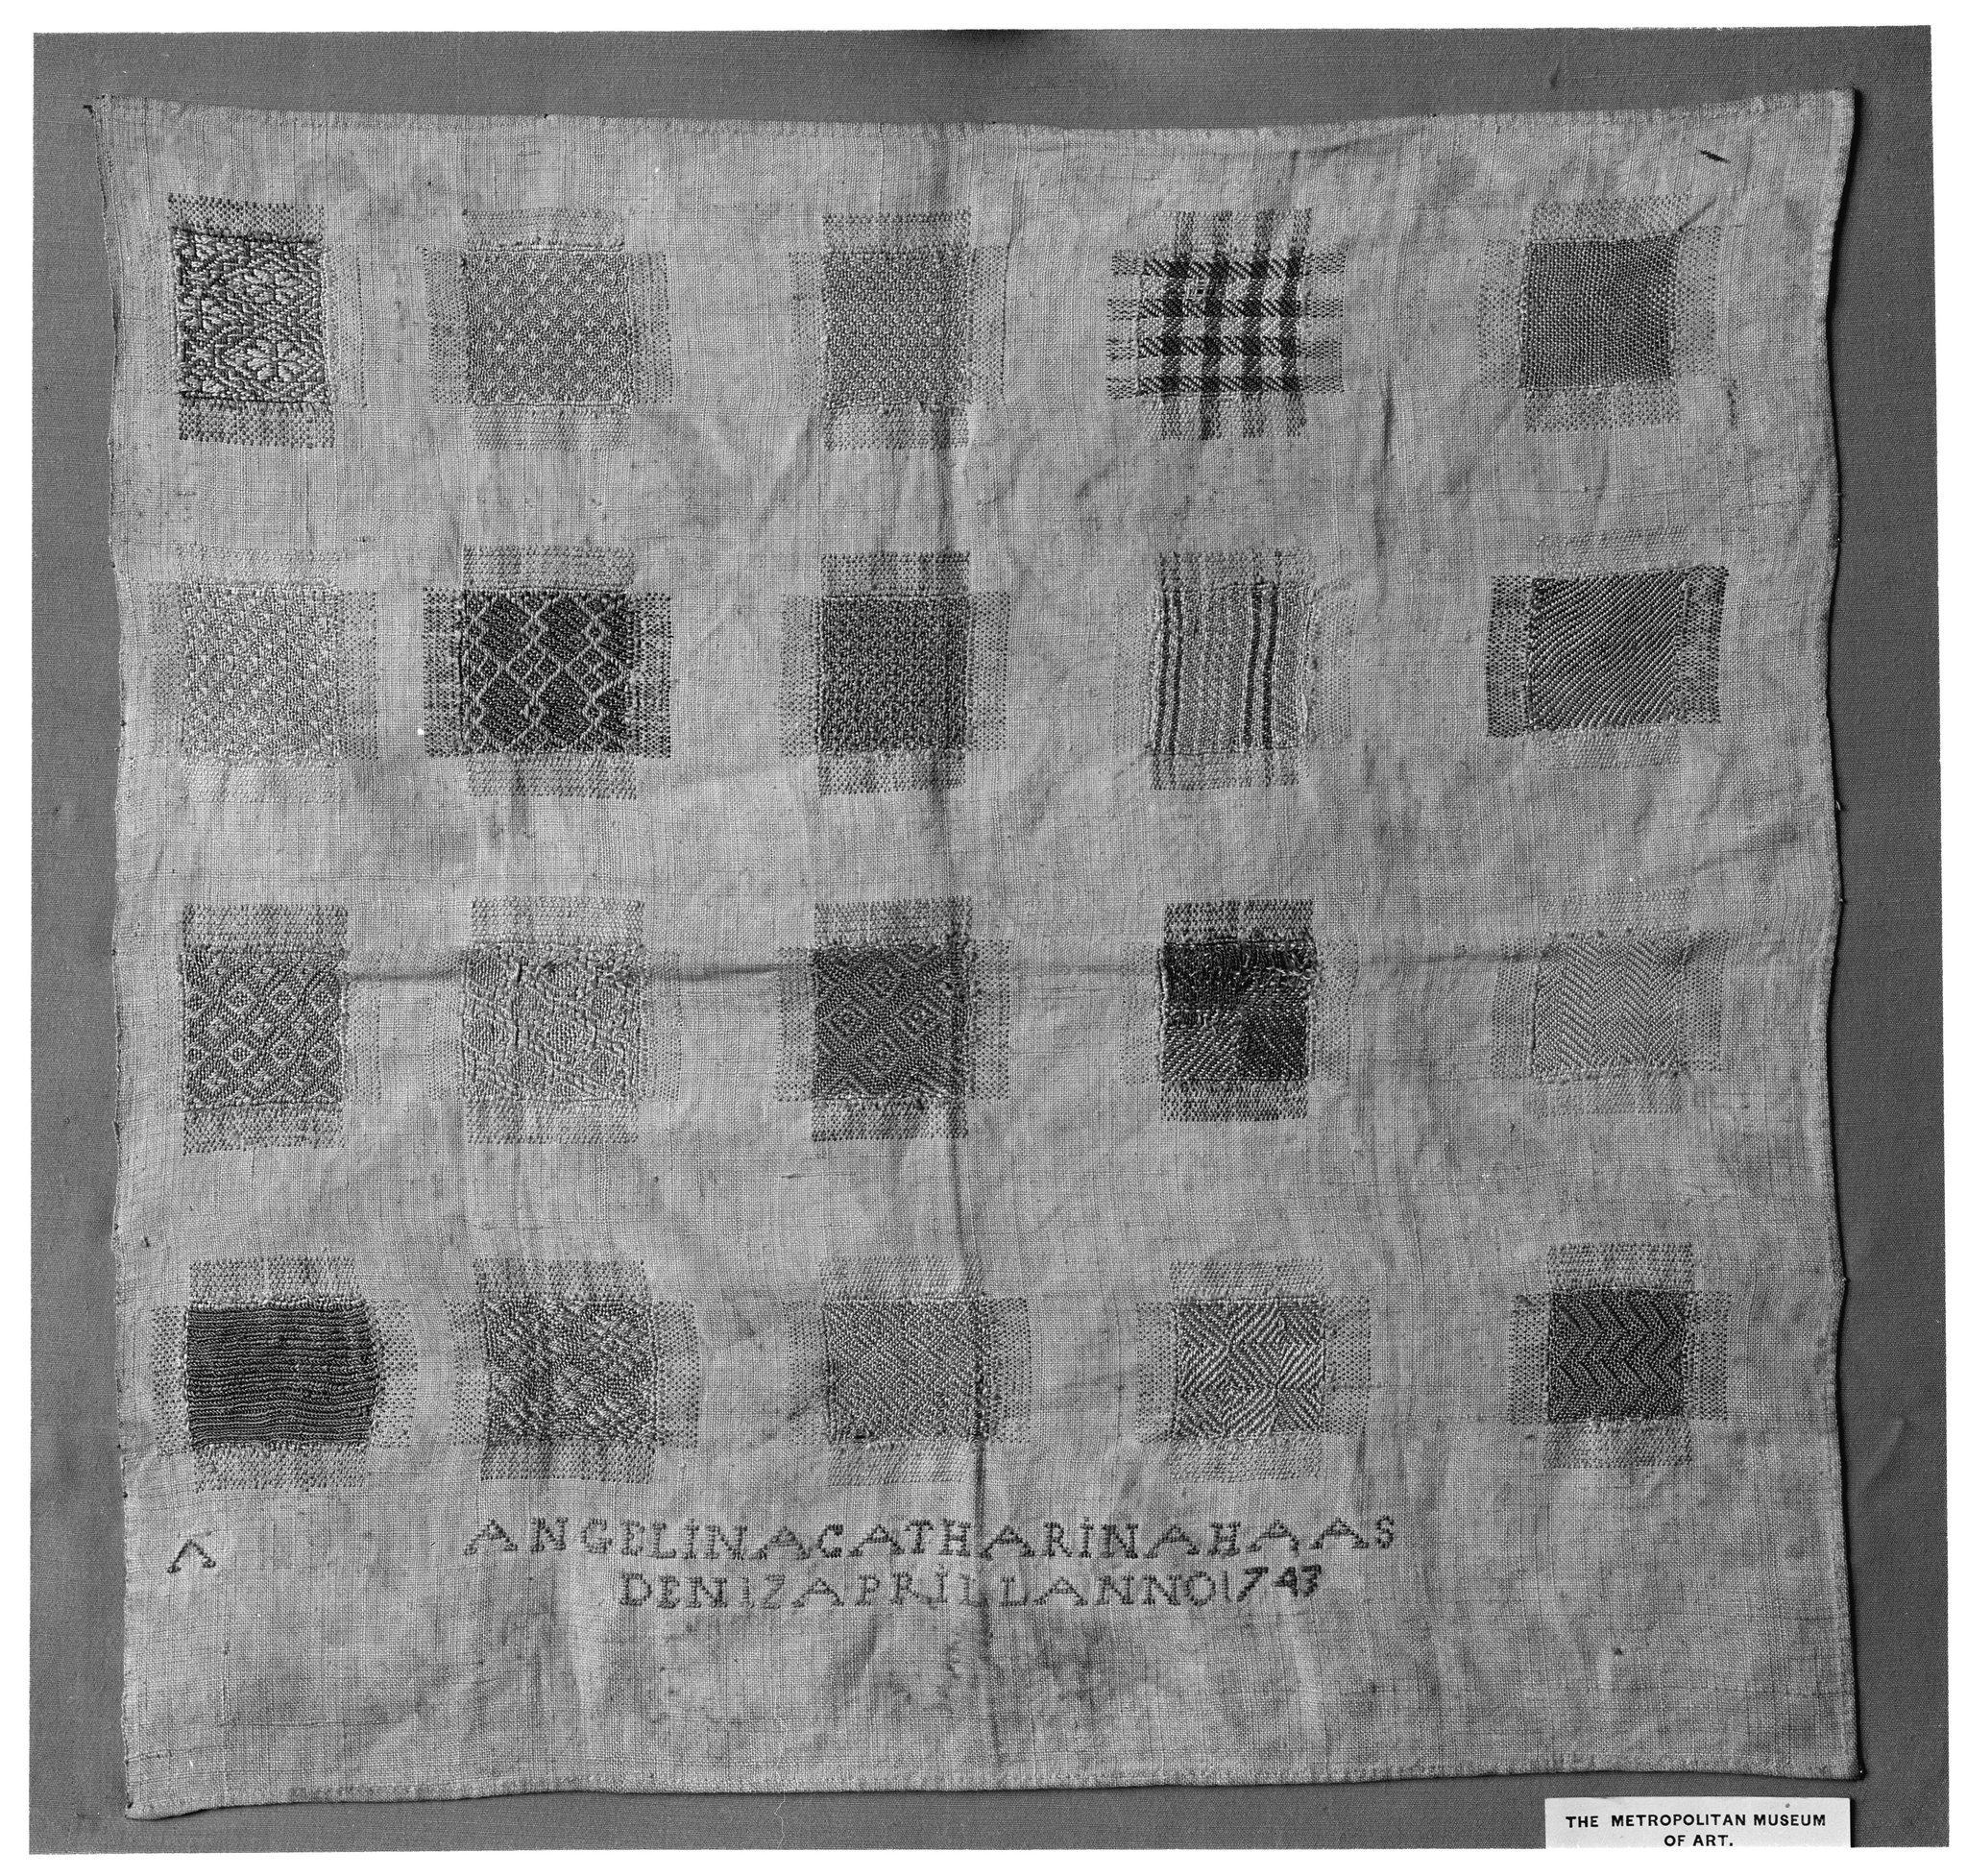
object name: sampler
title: Darning sampler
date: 1743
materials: linen, silk